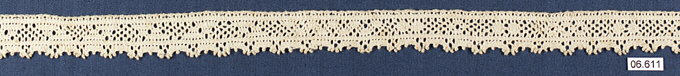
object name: edging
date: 1600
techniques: lace